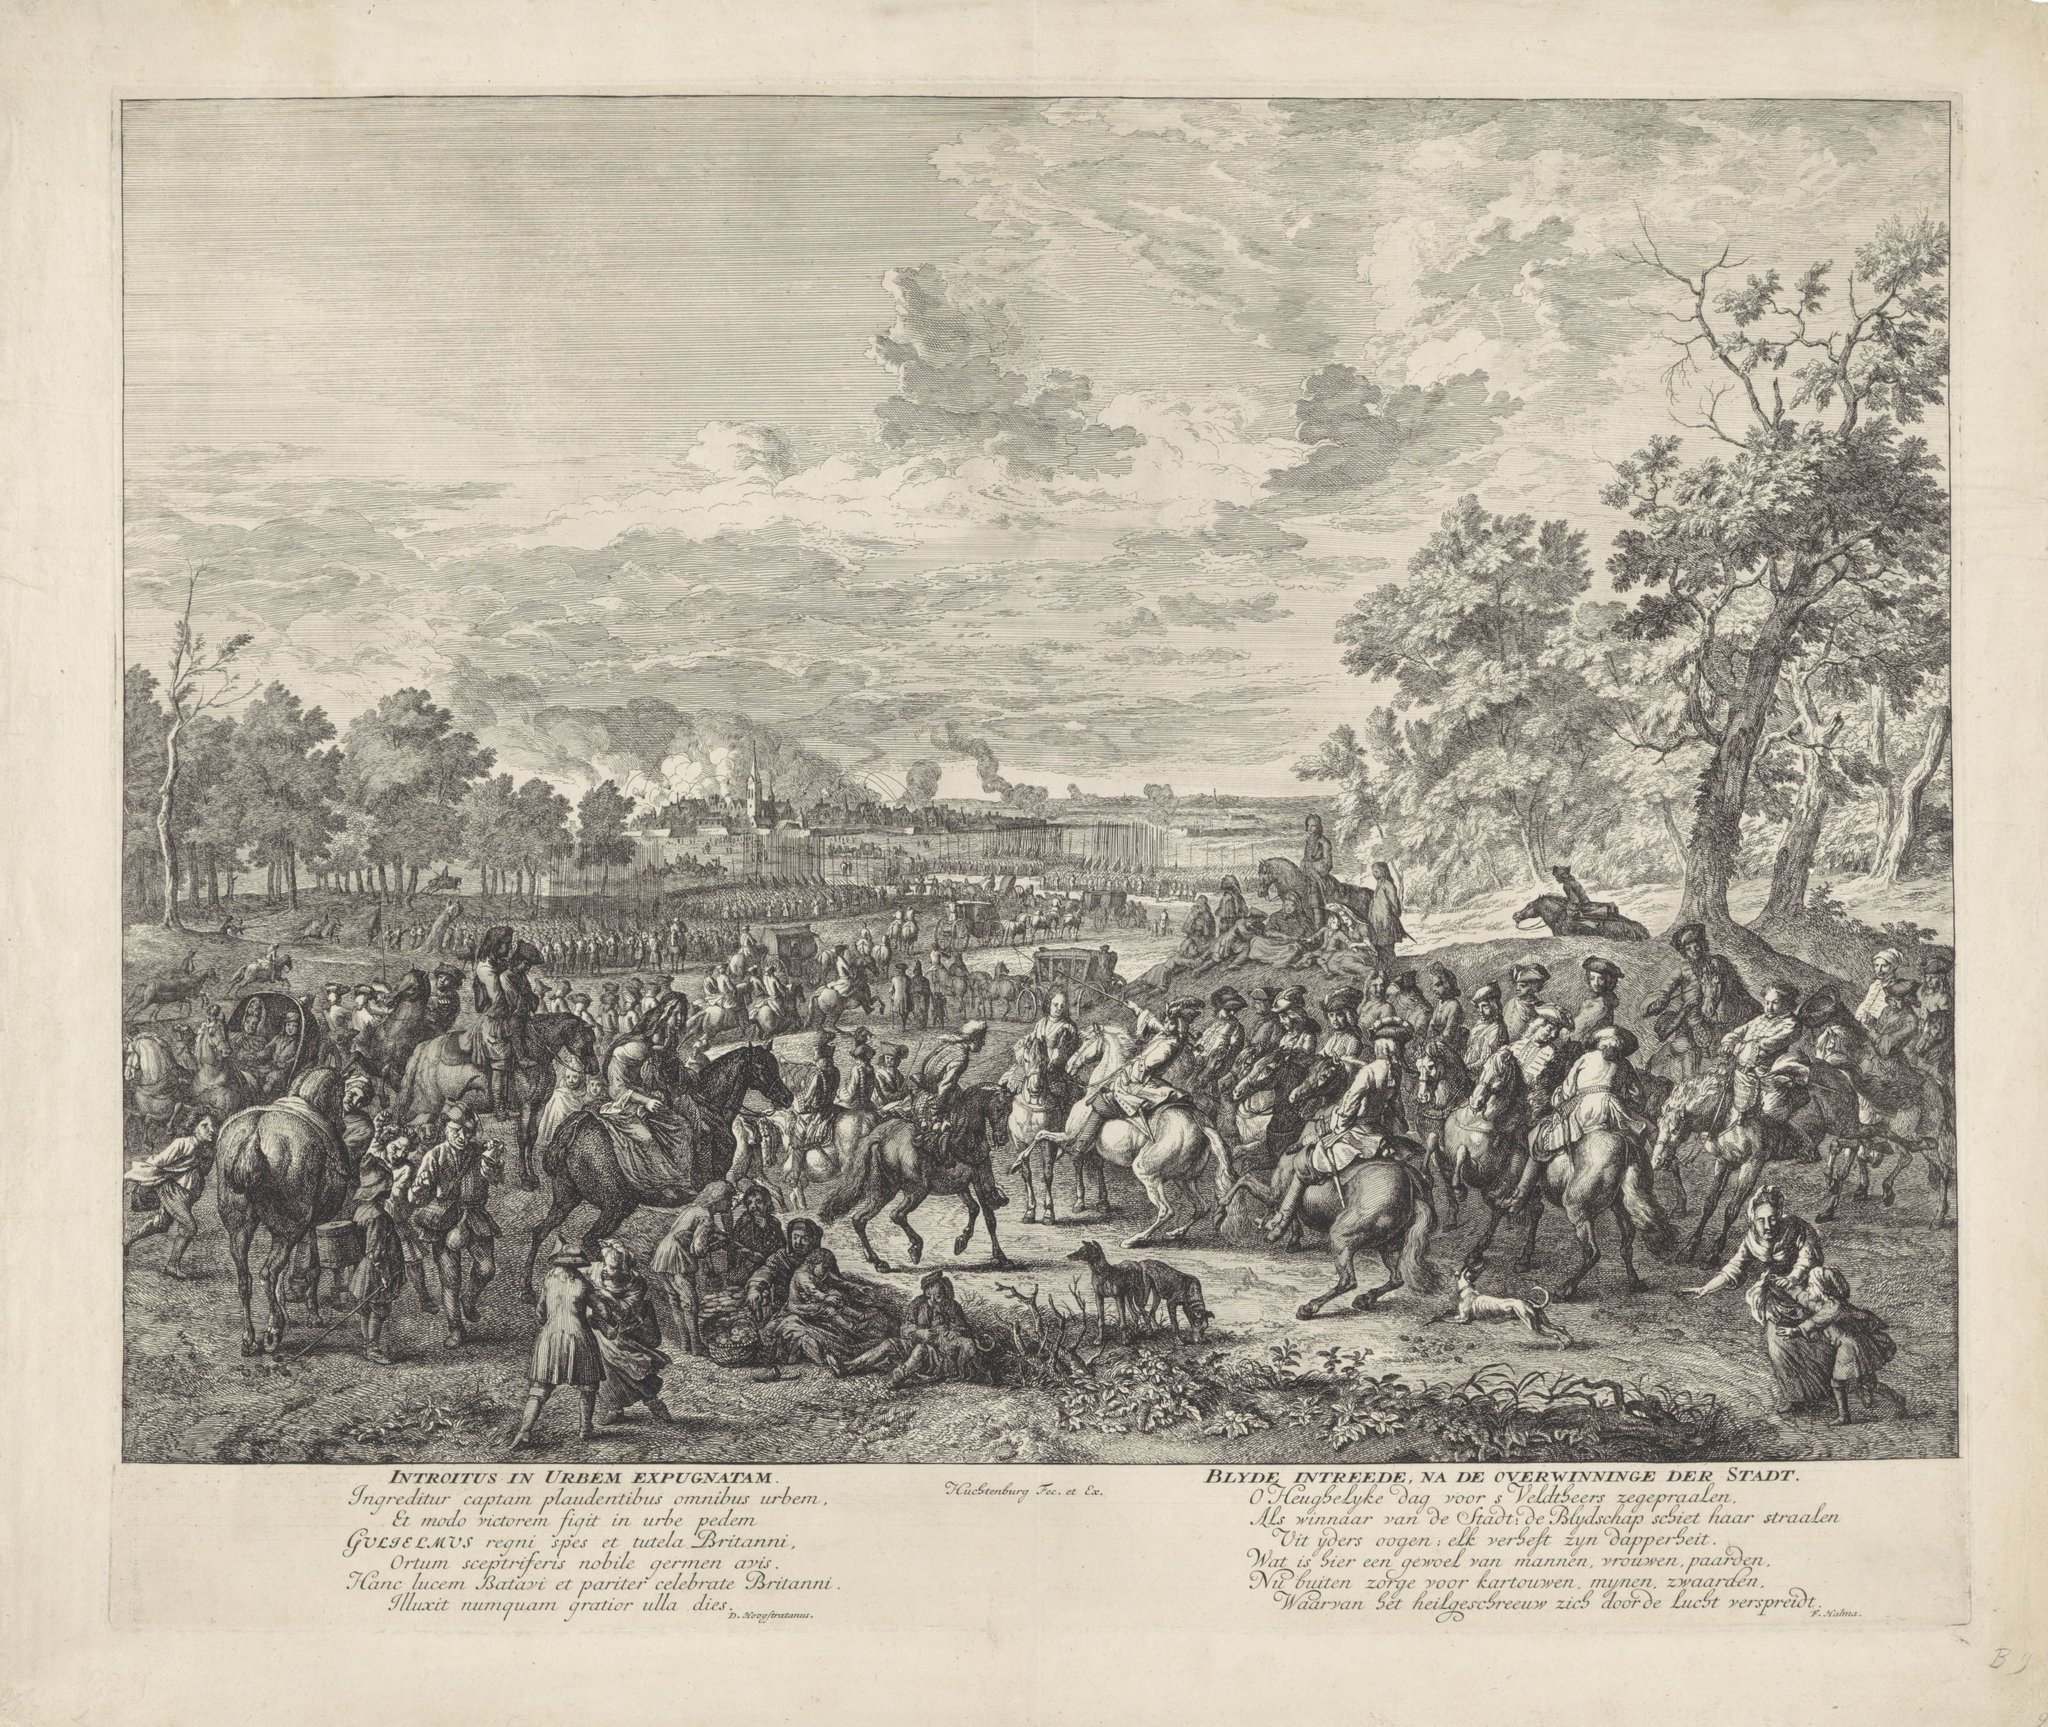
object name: print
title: Intrede in het veroverde Namen, 1695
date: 1695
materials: paper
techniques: etching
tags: march into the conquered place, siege, victory ~ armed conflict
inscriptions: collector's mark: Lugt 240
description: De legers van geallieerden maken zich gereed om op 4 augustus 1695 de veroverde stad Namen binnen te trekken. In de verte gaan de beschietingen van de citadel nog door. Op de voorgrond vrouwen, kinderen en honden. Onderaan in de marge een zesregelige tekst in het Latijn en een zesregelige tekst in het Nederlands.